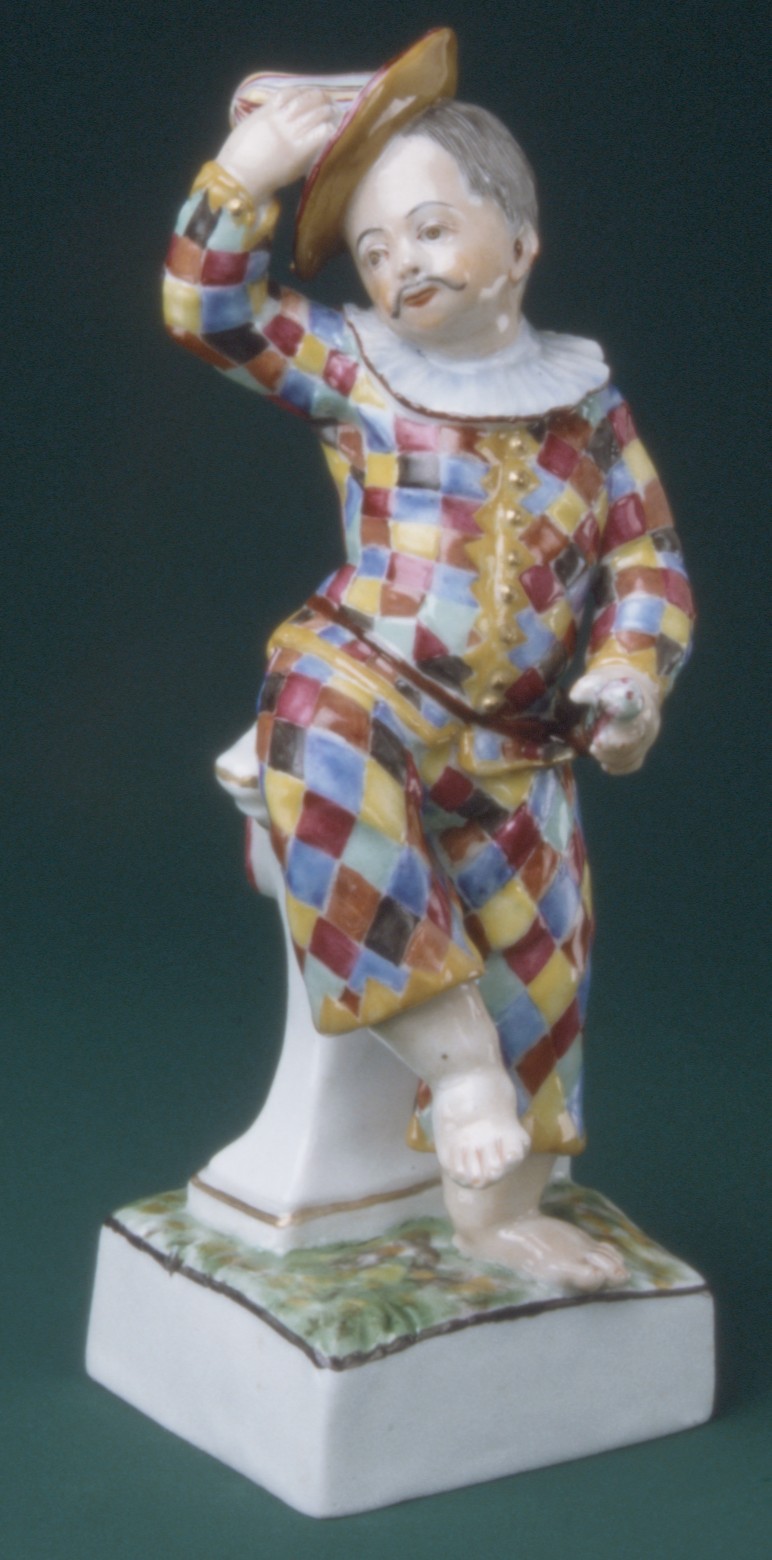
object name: figure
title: Harlequin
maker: gardner manufactory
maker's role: manufactory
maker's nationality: russian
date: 1770-1780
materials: hard paste porcelain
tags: men